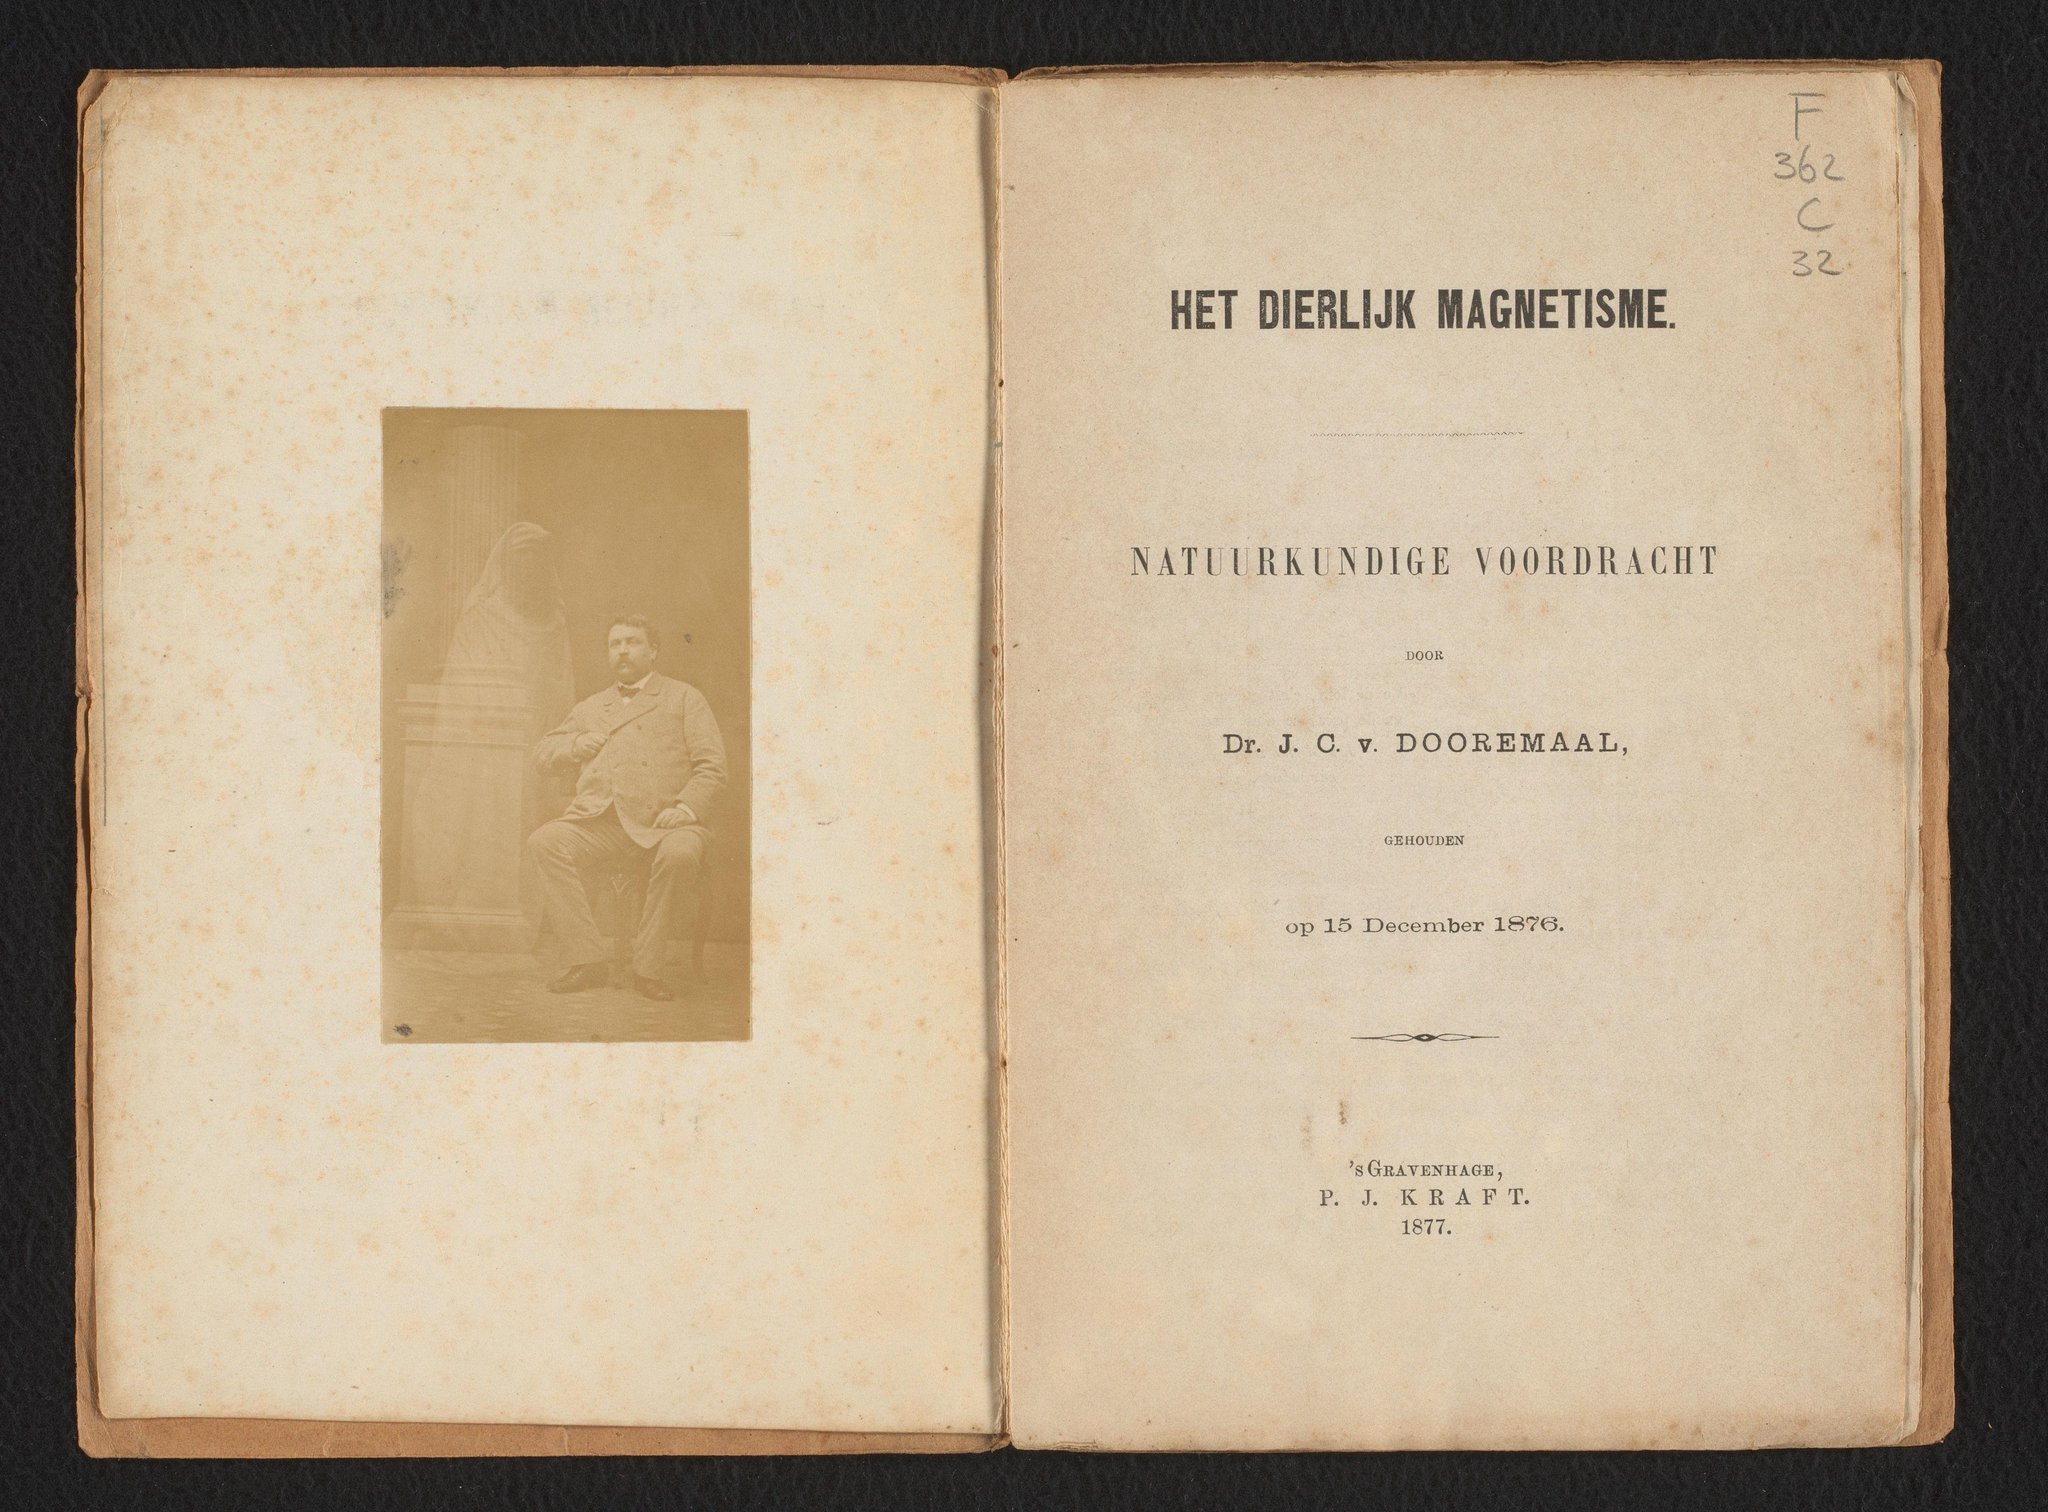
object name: book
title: Het dierlijk magnetisme. Natuurkundige voordracht door Dr. J.C. v. Dooremaal, gehouden op 15 December 1876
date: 1877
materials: paper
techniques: albumen print, letterpress printing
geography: the hague